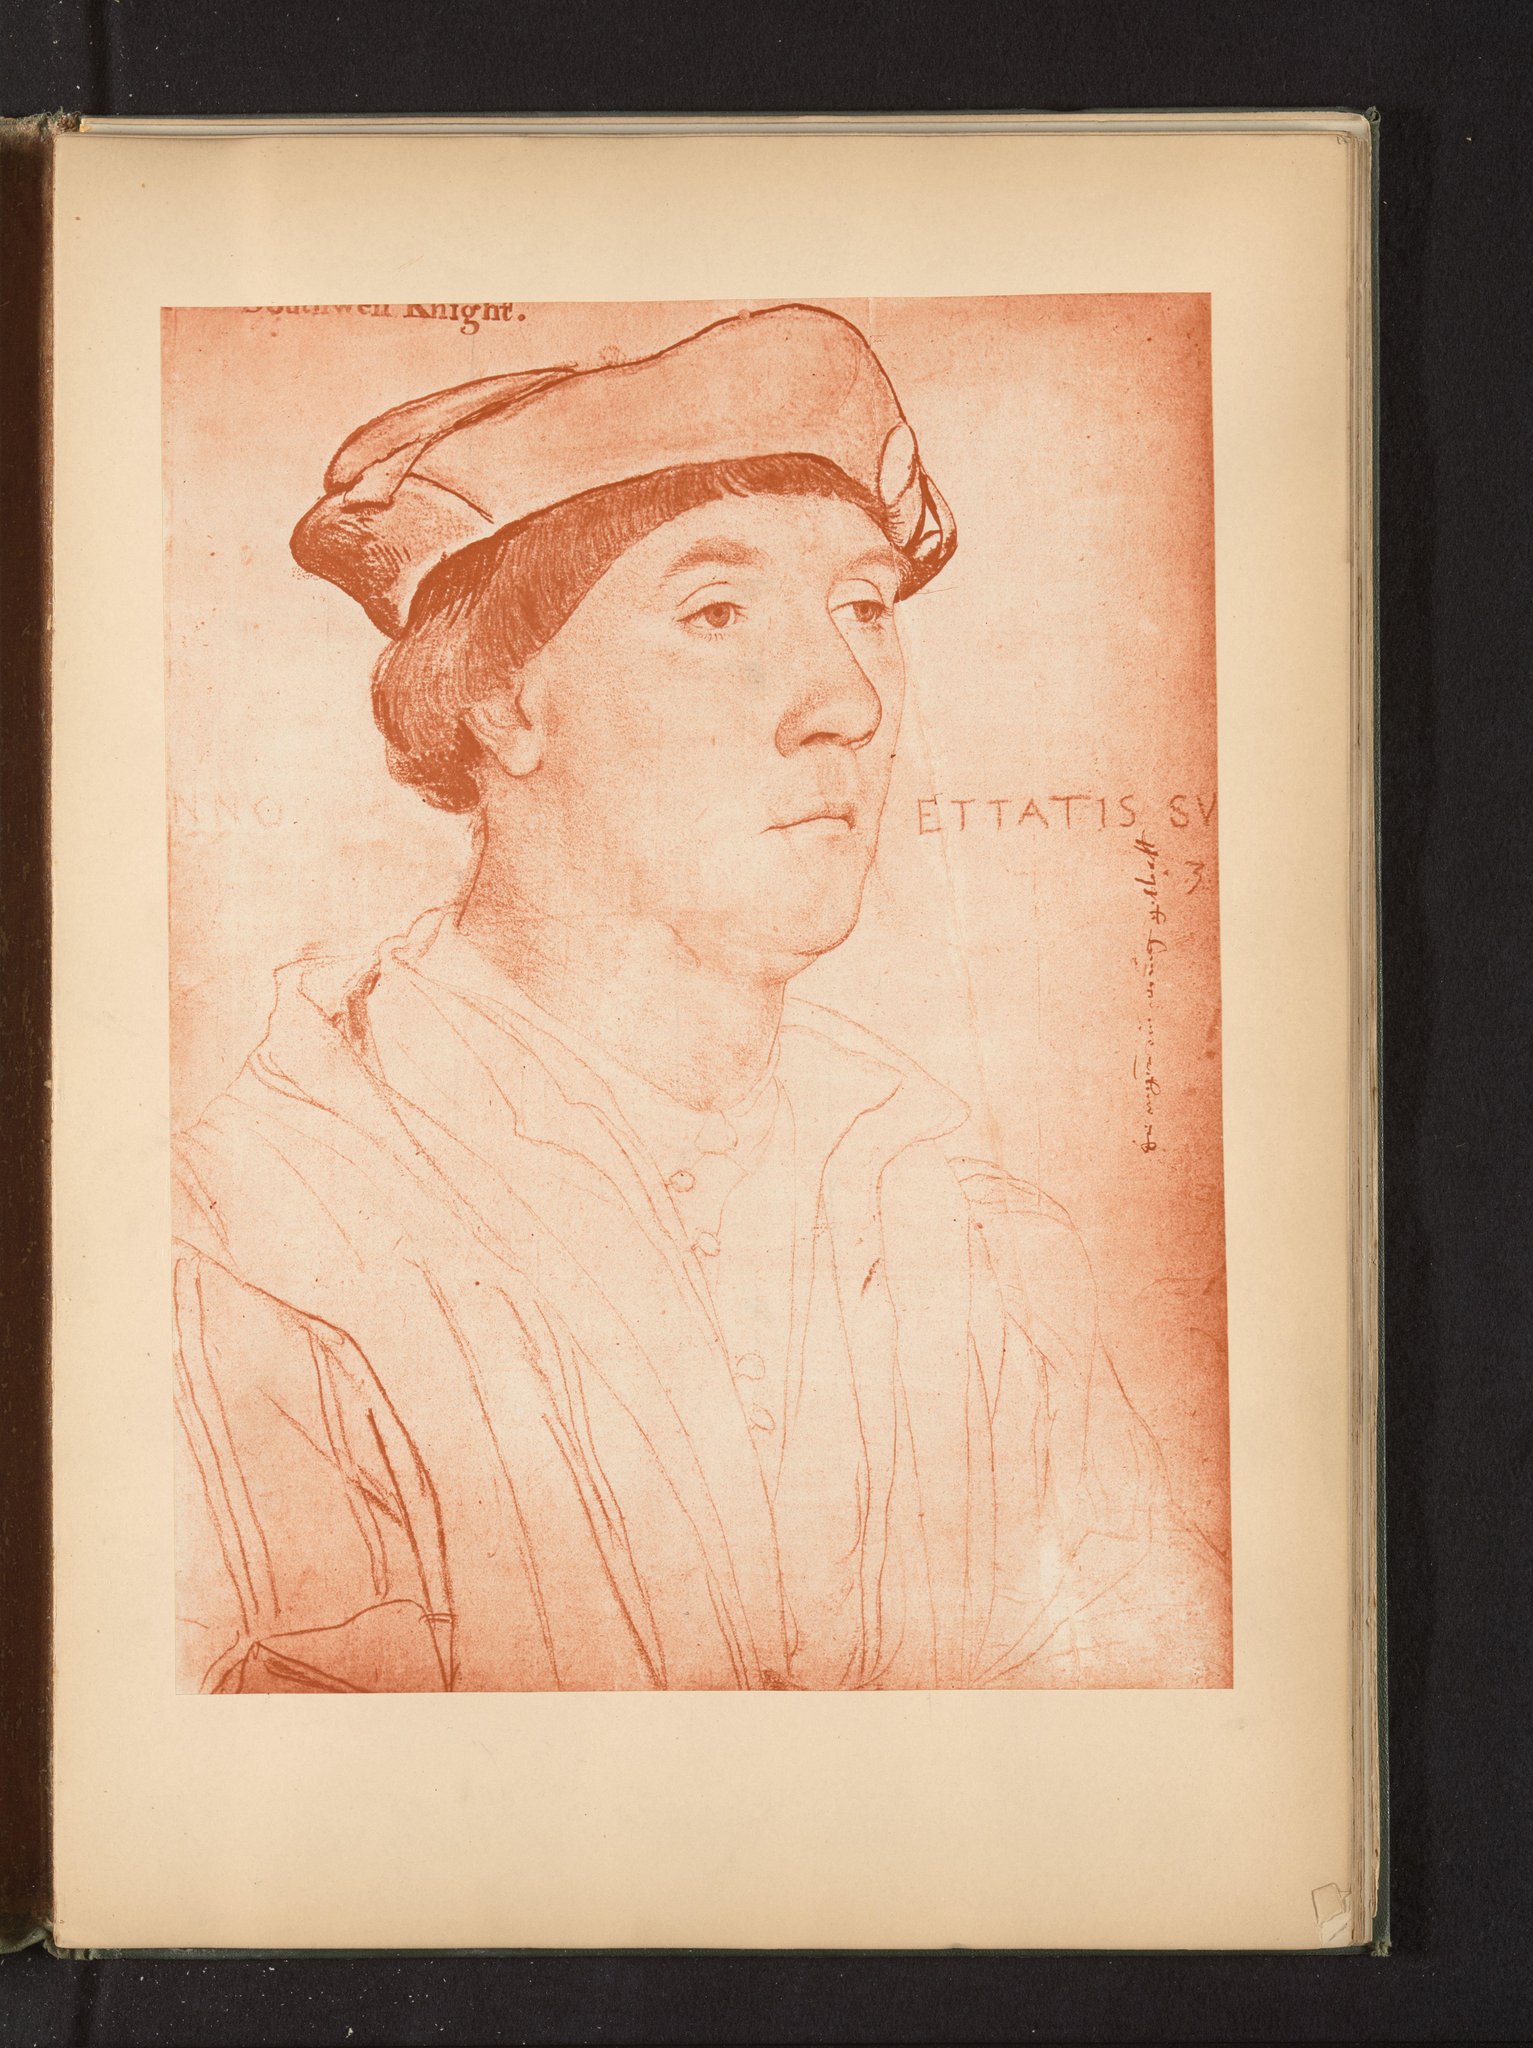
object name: page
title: Fotoreproductie van een portret van Richard Southwell door Hans Holbein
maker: Anonymous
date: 1872-1877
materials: paper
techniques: carbon print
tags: drawing, sketch, historical persons